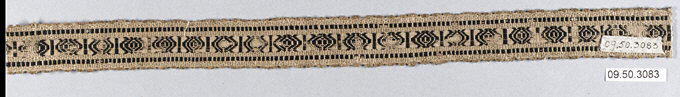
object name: gimp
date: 1701-1900